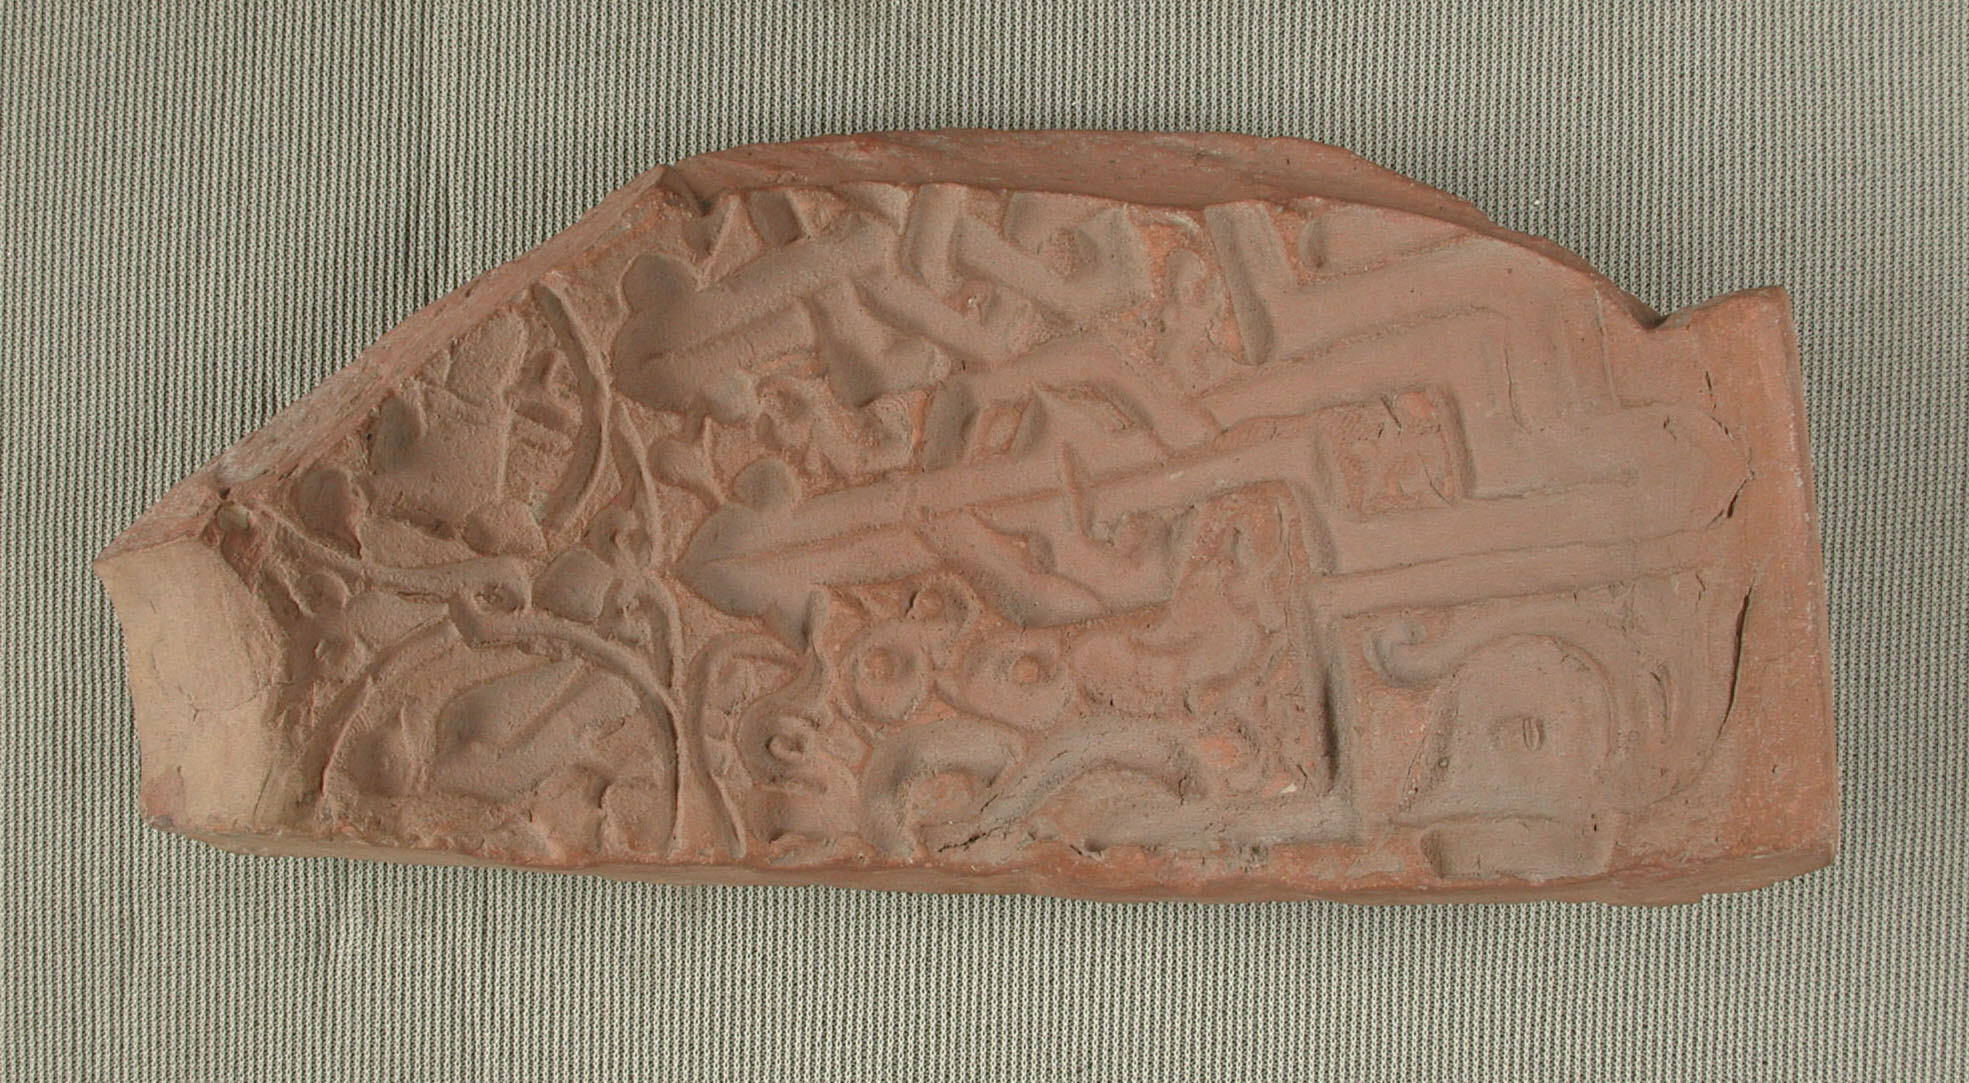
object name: mold fragment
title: Fragment of a Mold for Making Ceramics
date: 1001-1100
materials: earthenware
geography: iran